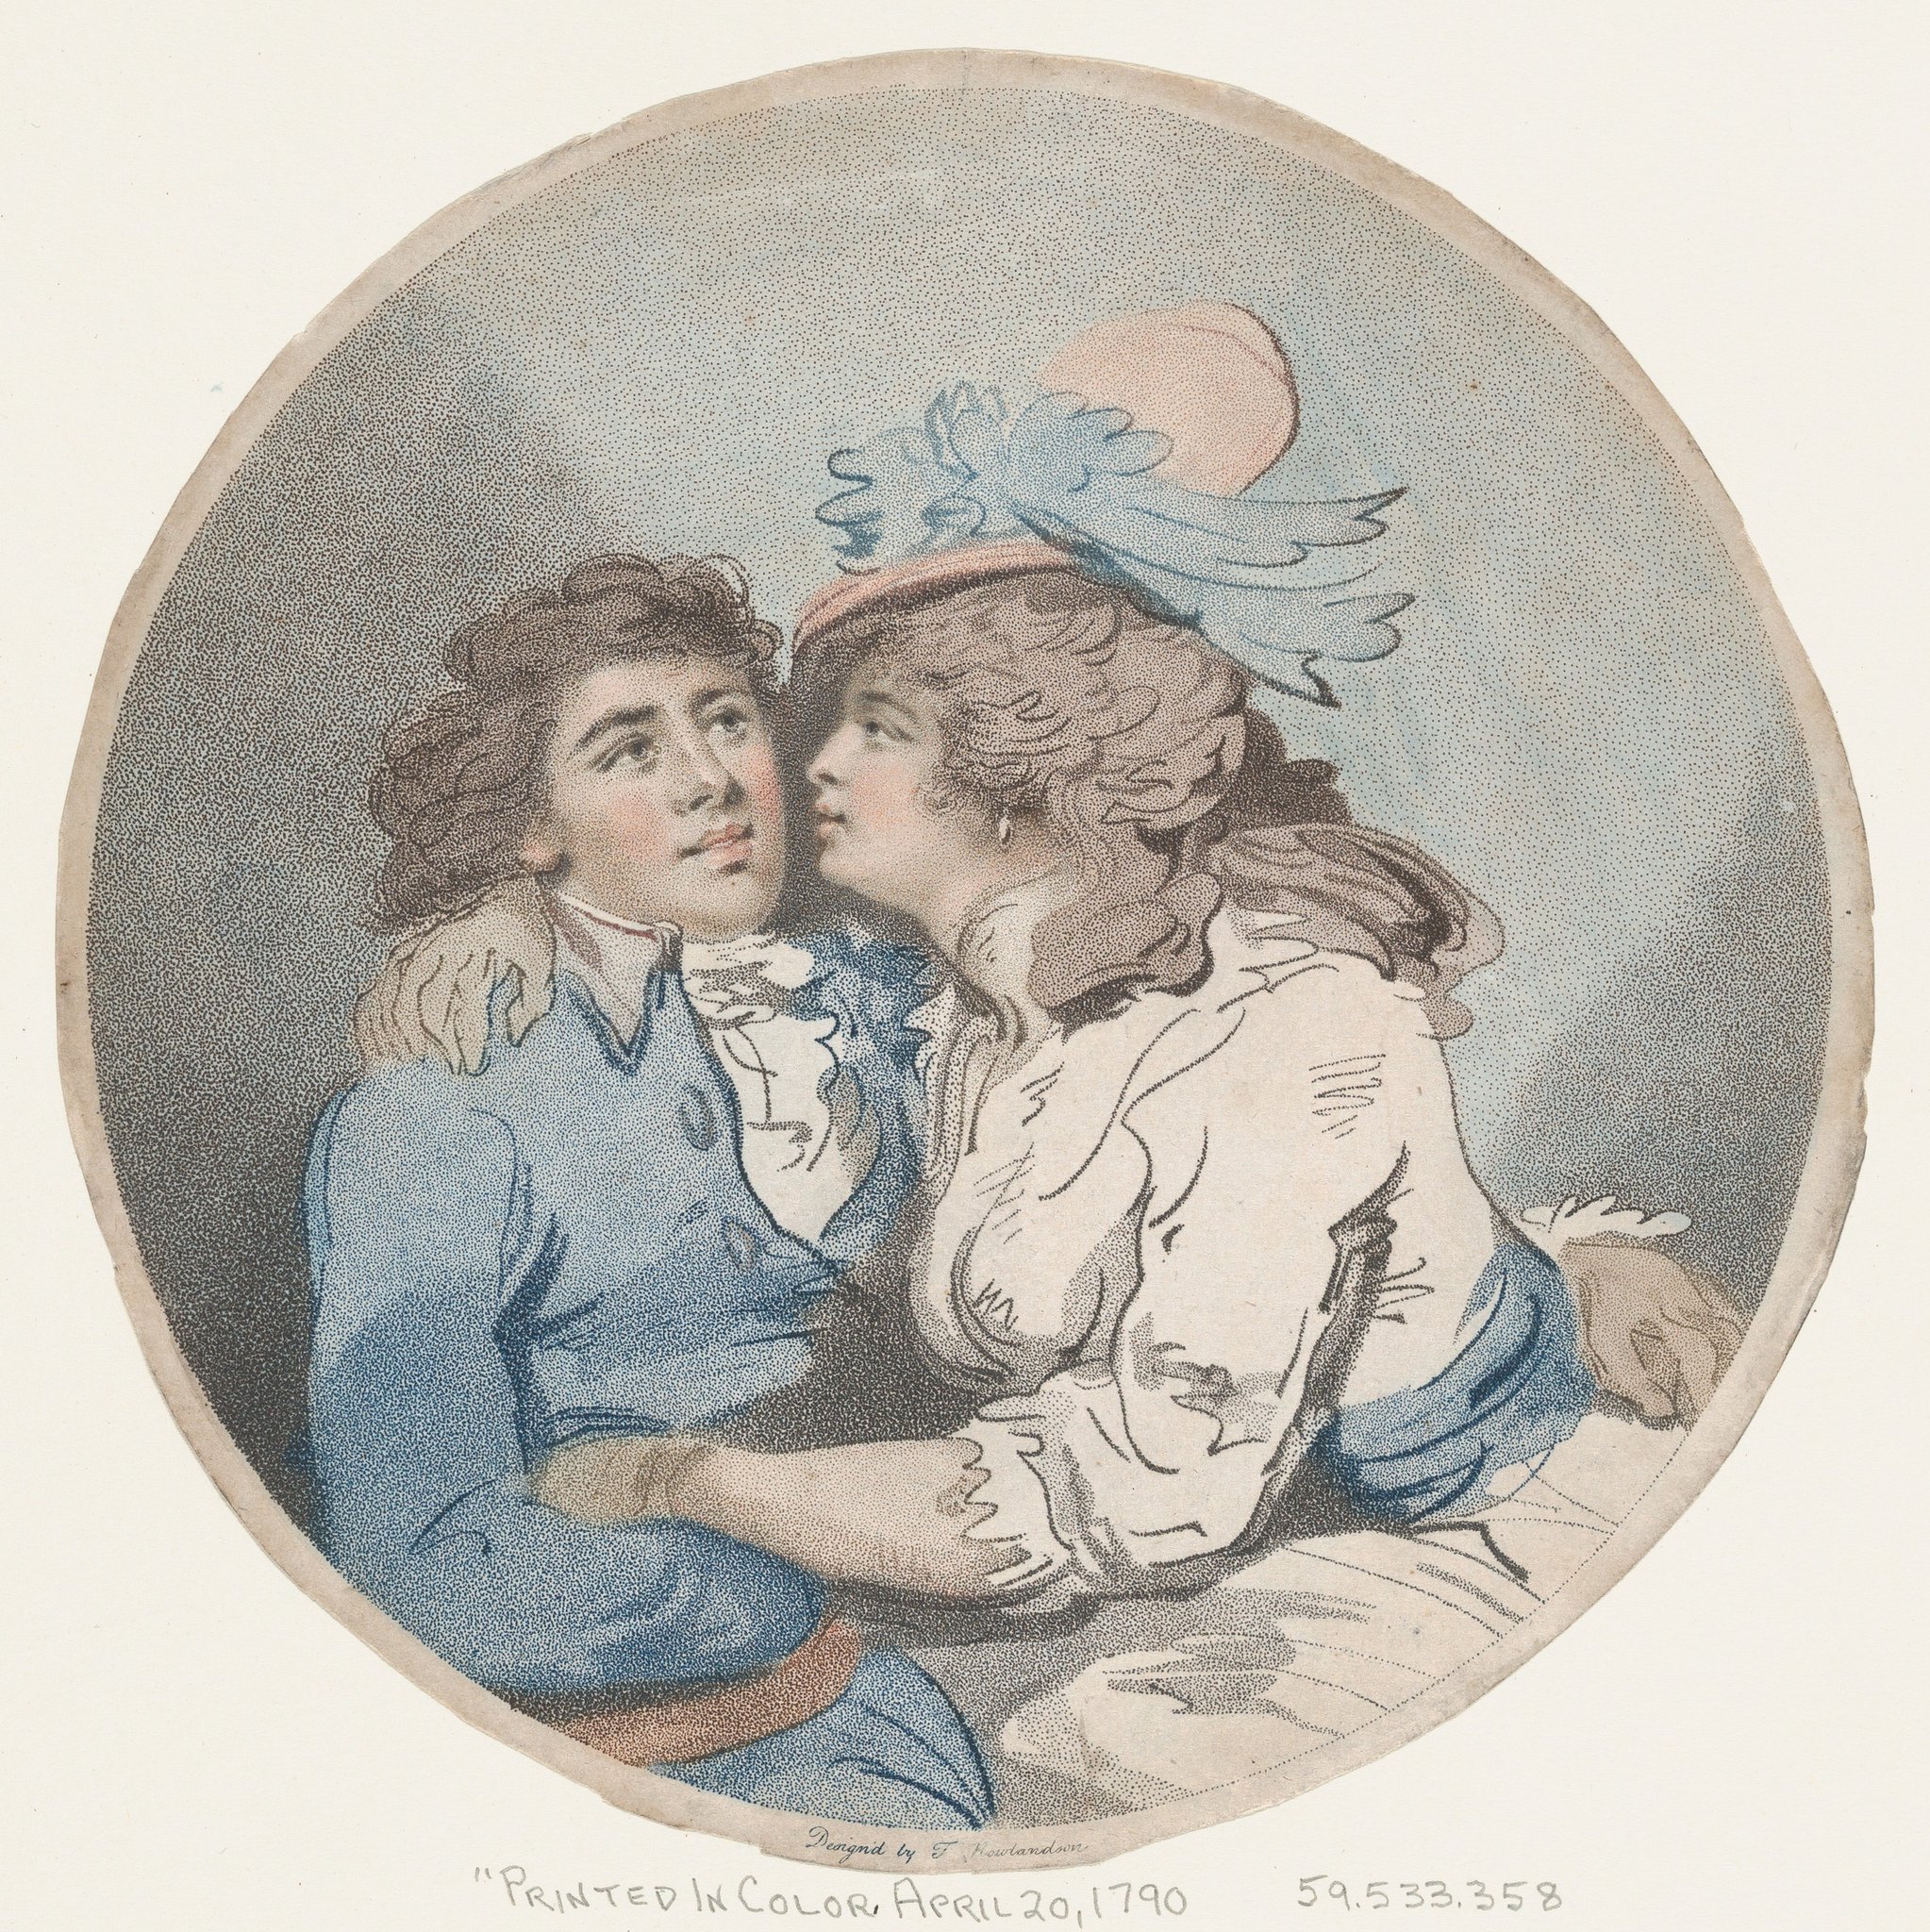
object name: print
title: Leap Year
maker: t. smith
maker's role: etcher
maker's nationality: british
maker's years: 1785-1787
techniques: aquatint, etching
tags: men,women